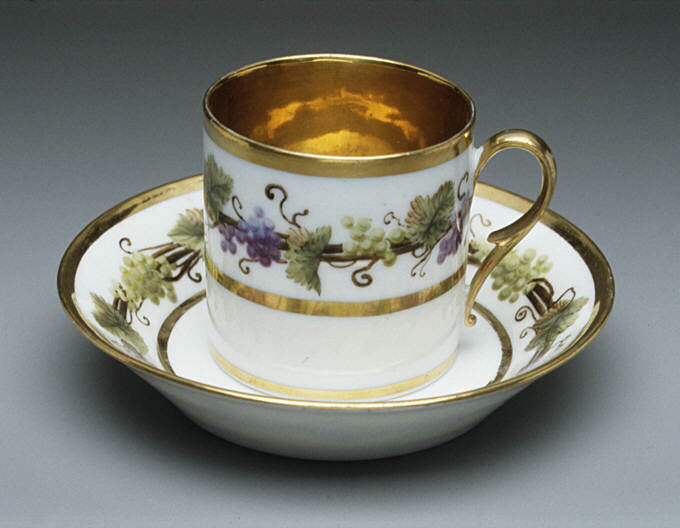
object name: cup and saucer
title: Cups and saucers (3)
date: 1800-1810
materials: hard paste porcelain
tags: grapes